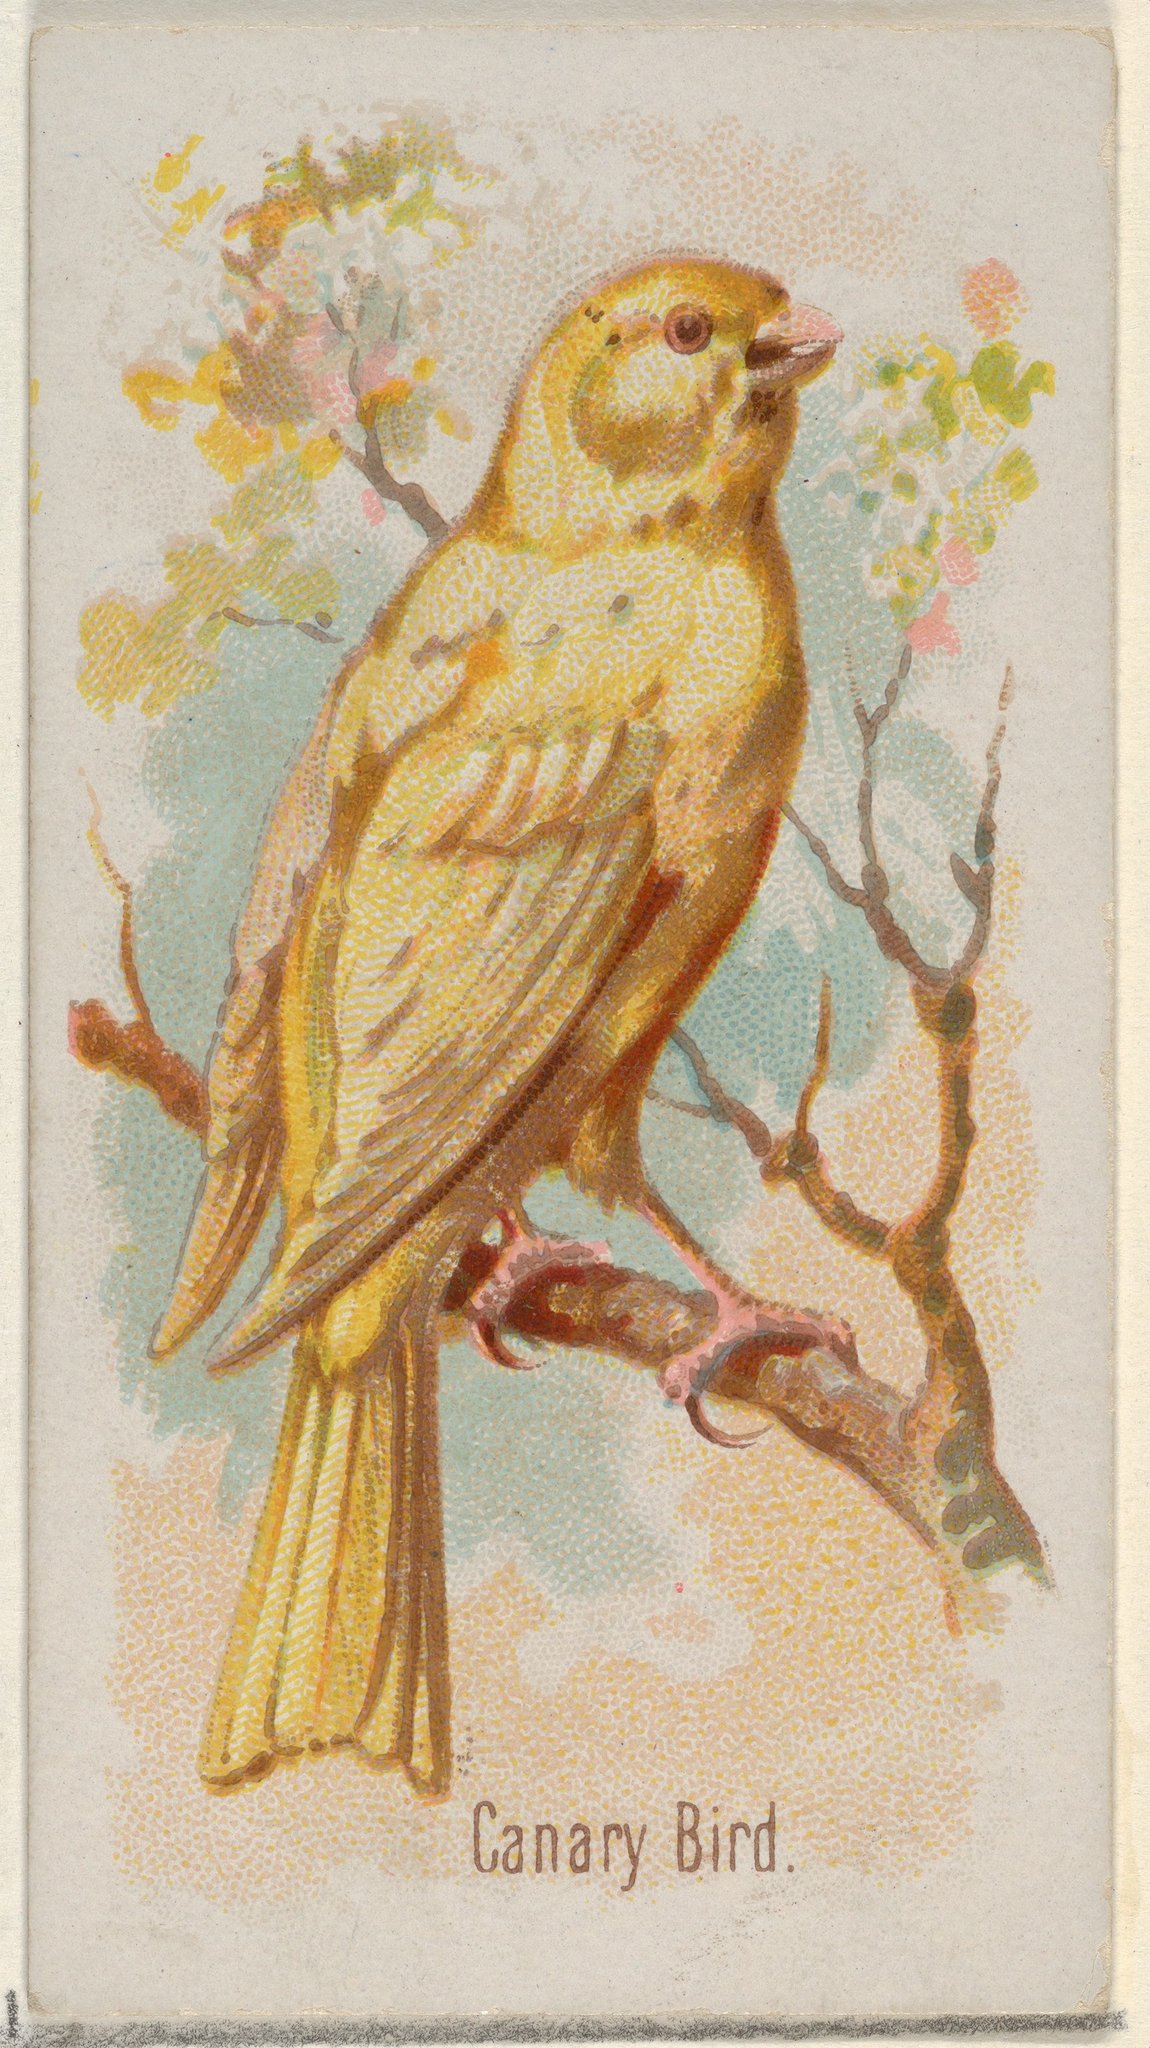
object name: print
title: Canary Bird, from the Song Birds of the World series (N23) for Allen & Ginter Cigarettes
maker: allen & ginter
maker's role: publisher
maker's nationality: american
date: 1890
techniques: color lithograph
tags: birds